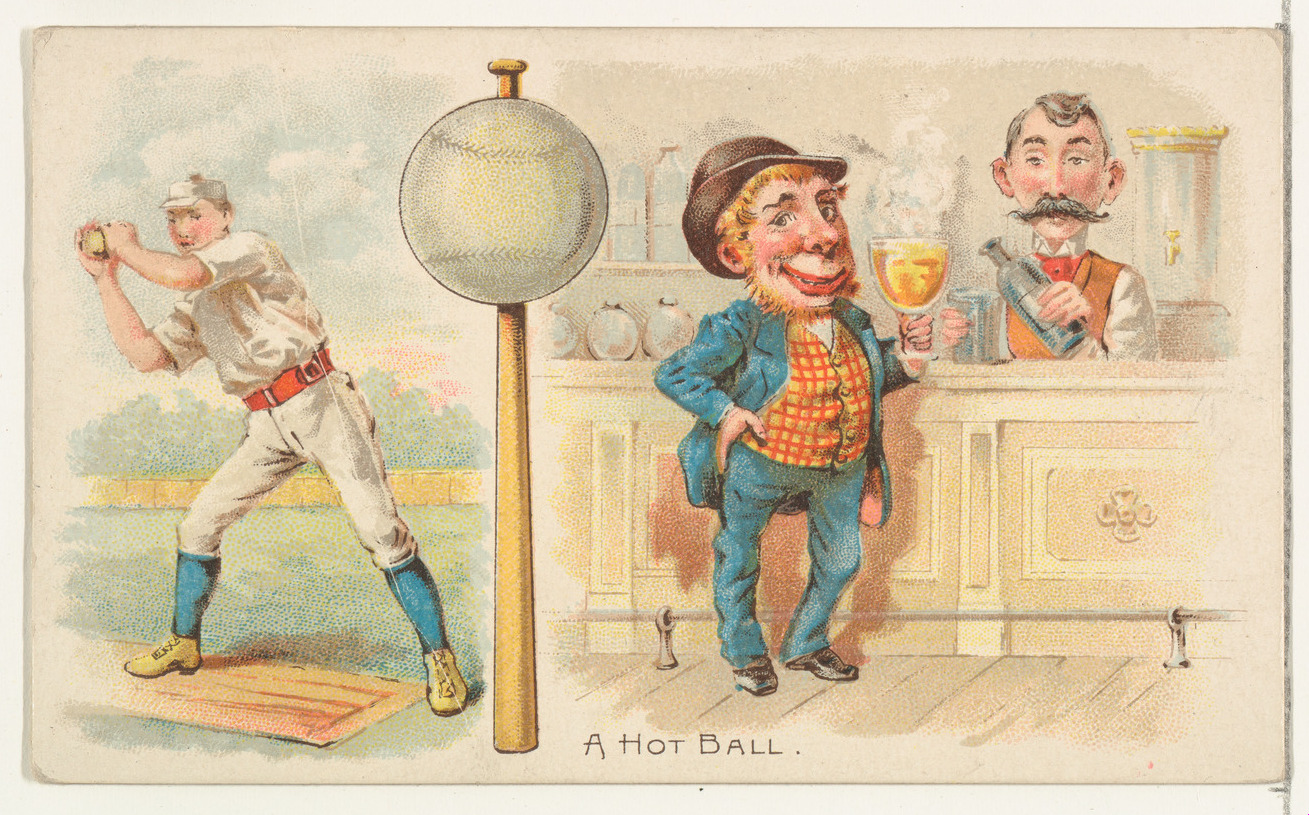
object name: print, baseball card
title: A Hot Ball, from the Talk of the Diamond set (N135) issued by Duke Sons & Co., a branch of the American Tobacco Company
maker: w. duke, sons & co.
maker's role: publisher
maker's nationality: american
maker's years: 1870-1920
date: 1888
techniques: color lithograph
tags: men,baseball,drinking,athletes